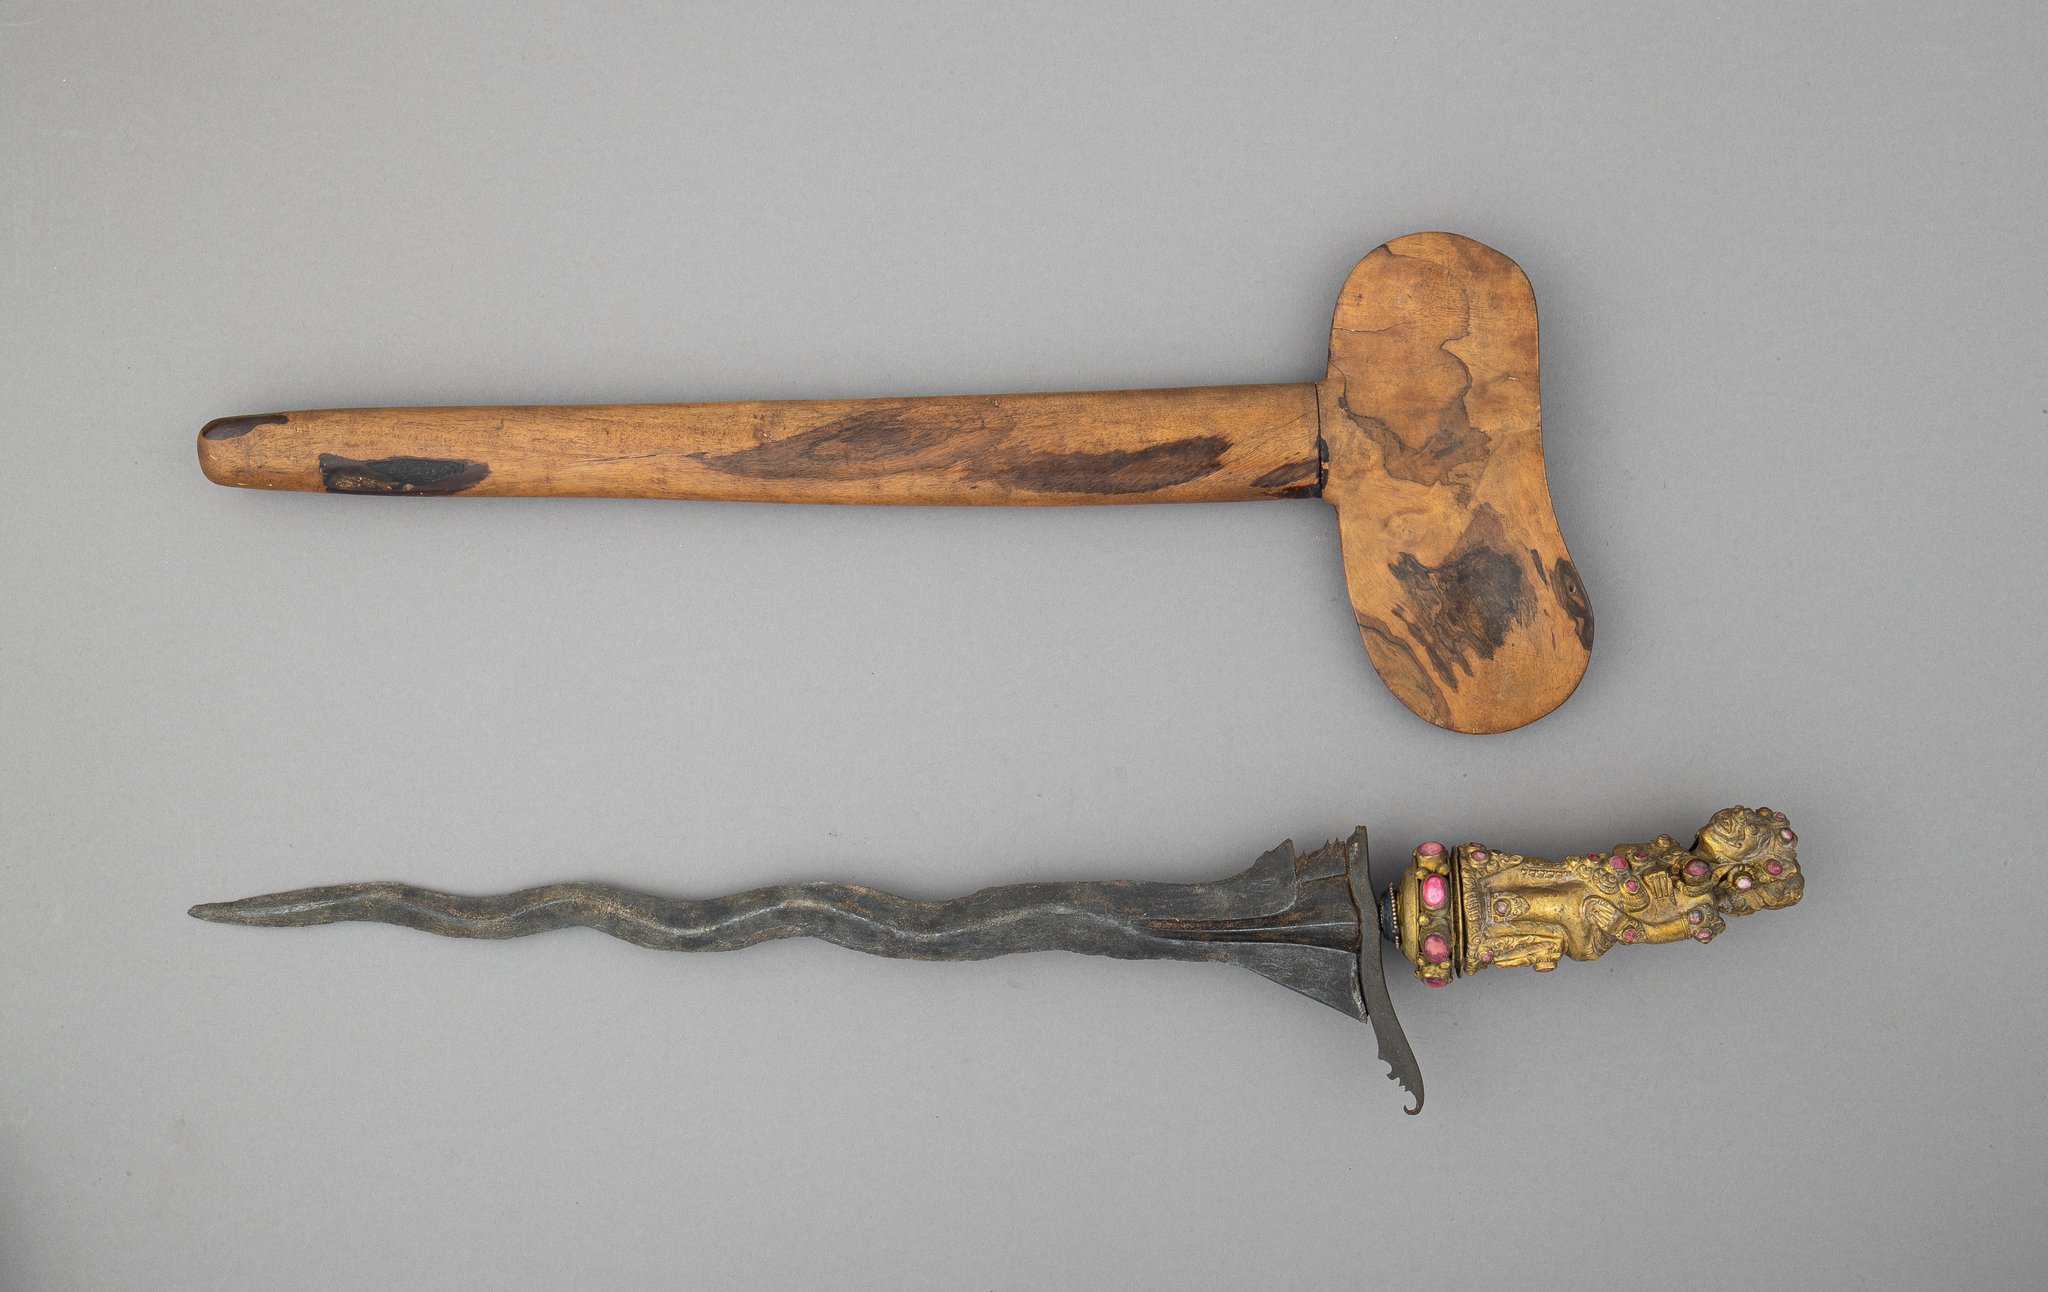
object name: kris with sheath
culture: balinese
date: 1501-1900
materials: copper alloy, gold, steel, stone, wood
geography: indonesia